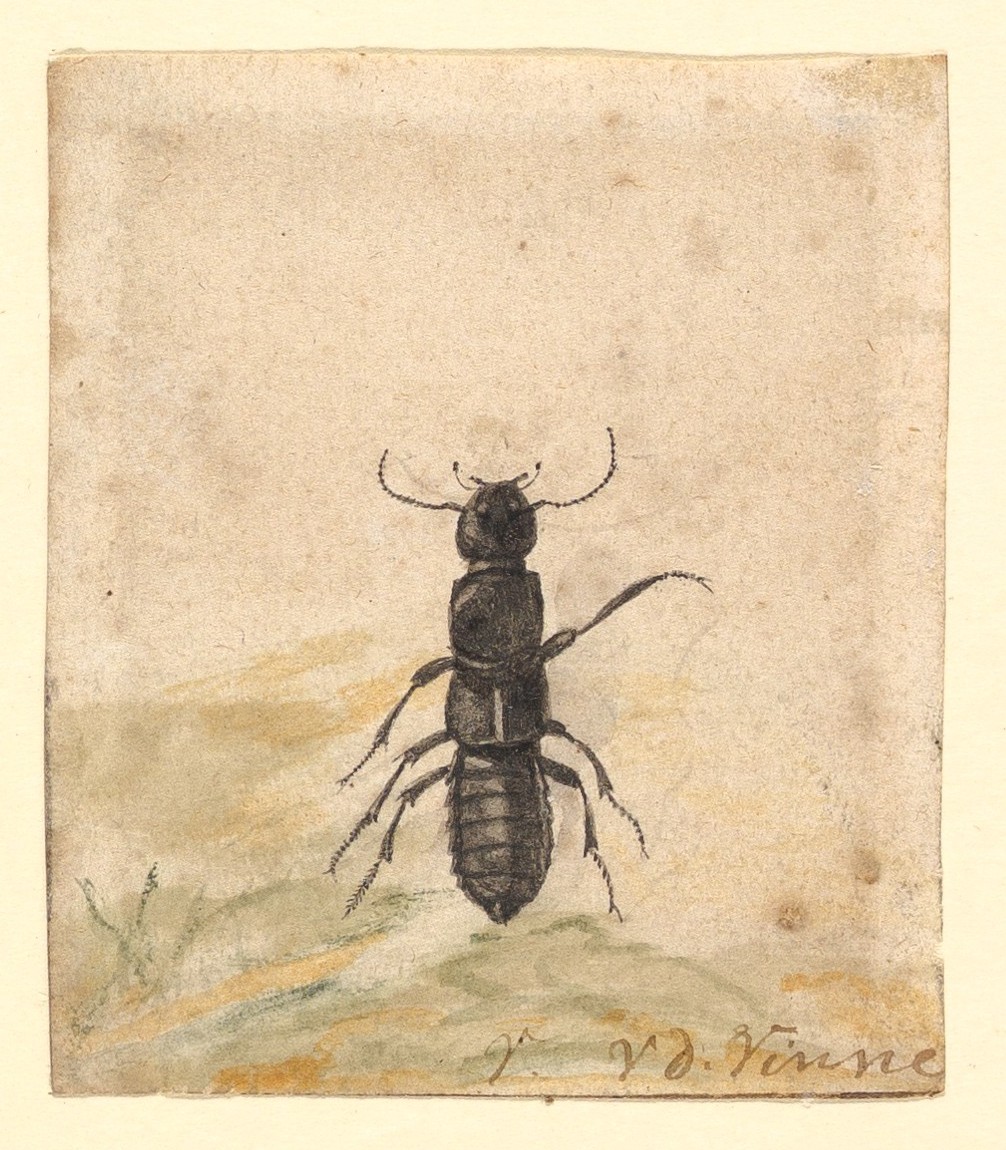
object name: drawing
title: A Black Beetle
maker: vincent laurensz van der vinne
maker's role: artist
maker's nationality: dutch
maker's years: 1628-1702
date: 1667-1700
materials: watercolor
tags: insects